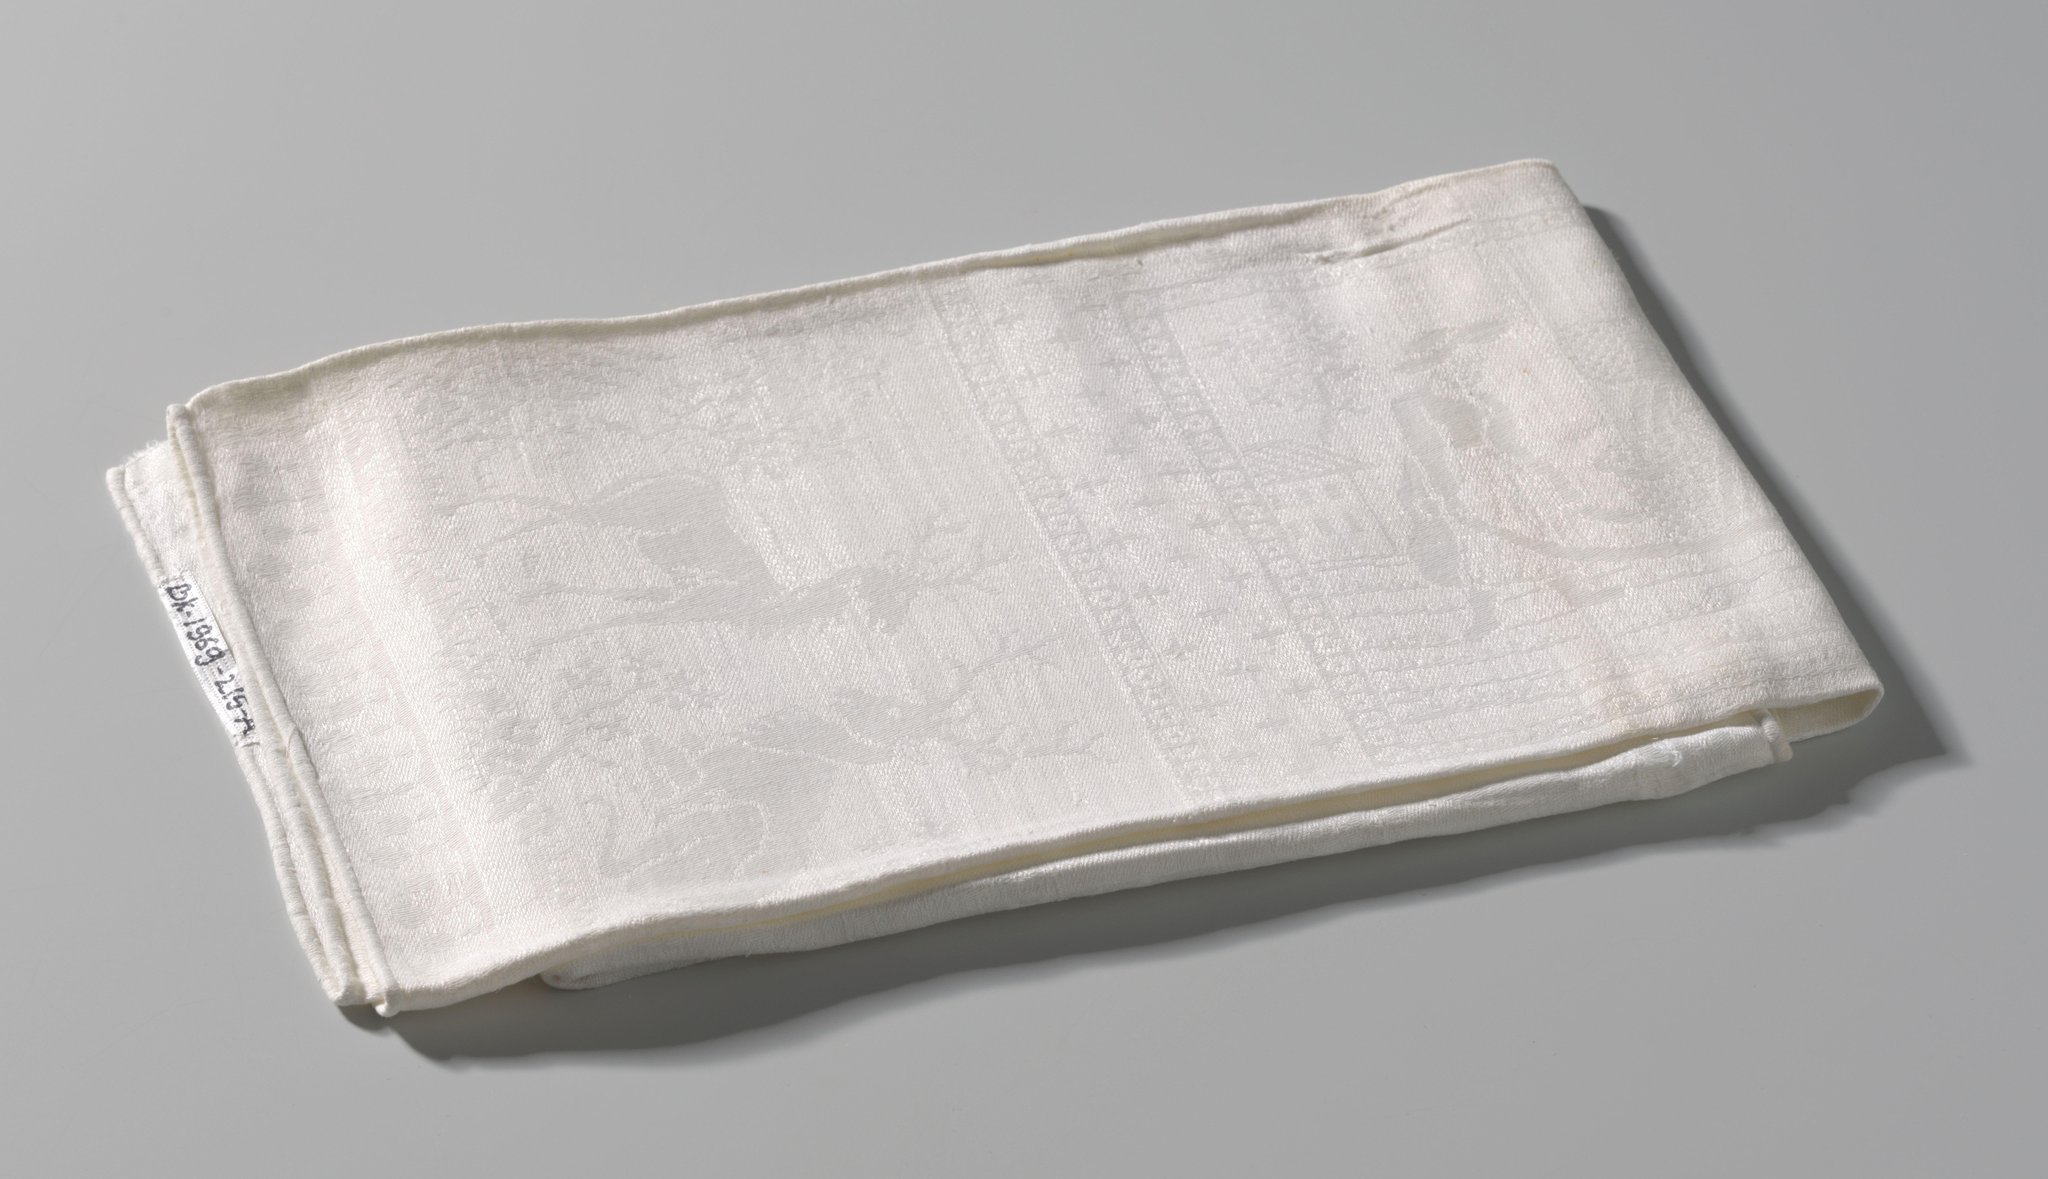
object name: napkin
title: Servet met landelijke scènes, gemerkt BdW en 24.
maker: Anonymous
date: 1830-1860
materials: cotton, linen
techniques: damask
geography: germany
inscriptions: mark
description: Wit halflinnen damasten servet met landelijke taferelen, gemerkt BdW en 24.